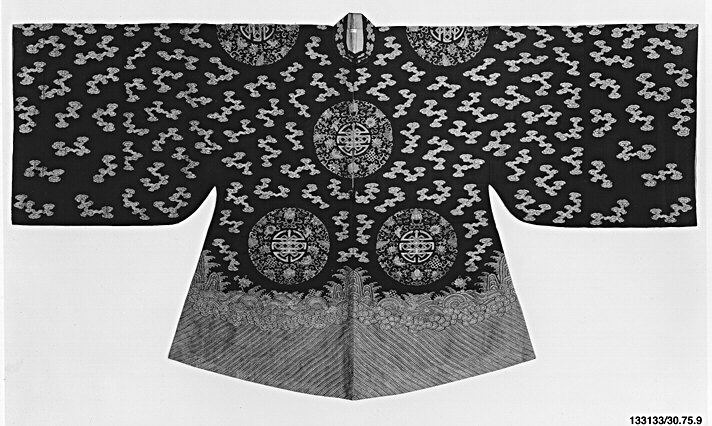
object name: coat, ceremonial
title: Ceremonial Coat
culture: chinese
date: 1644-1911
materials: metal thread, silk